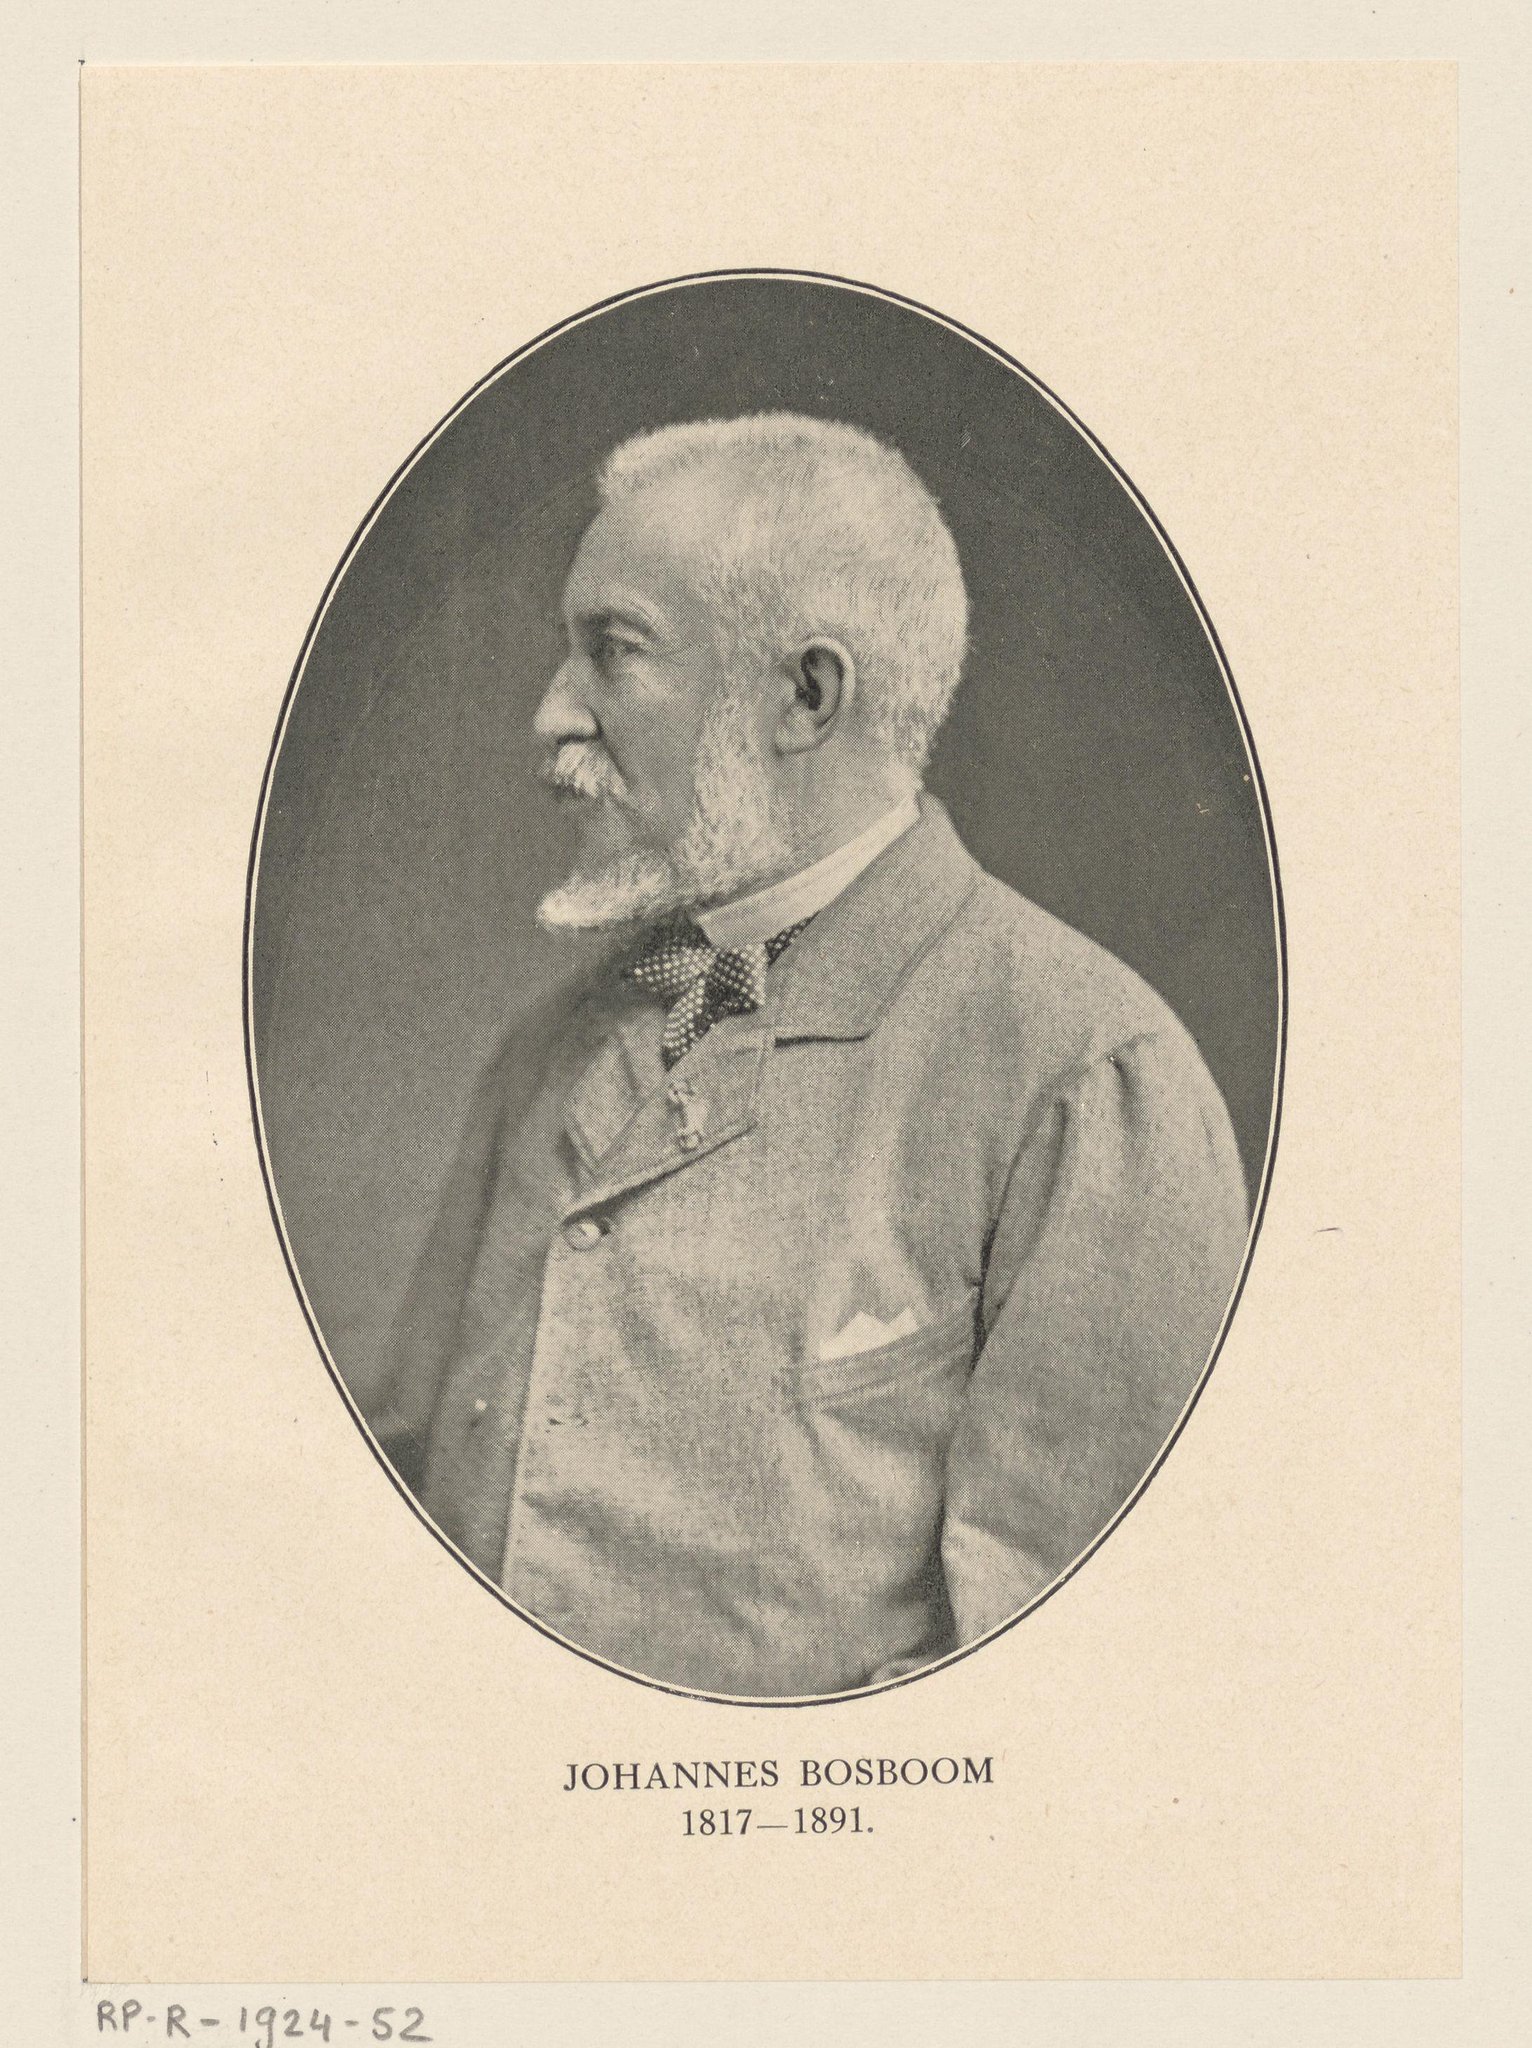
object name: photomechanical print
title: Portret van Johannes Bosboom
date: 1882-1924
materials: paper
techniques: autotype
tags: the hague, painter, print maker, draughtsman, johannes bosboom, historical persons, portrait, self-portrait of painter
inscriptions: collector's mark: Lugt 2233